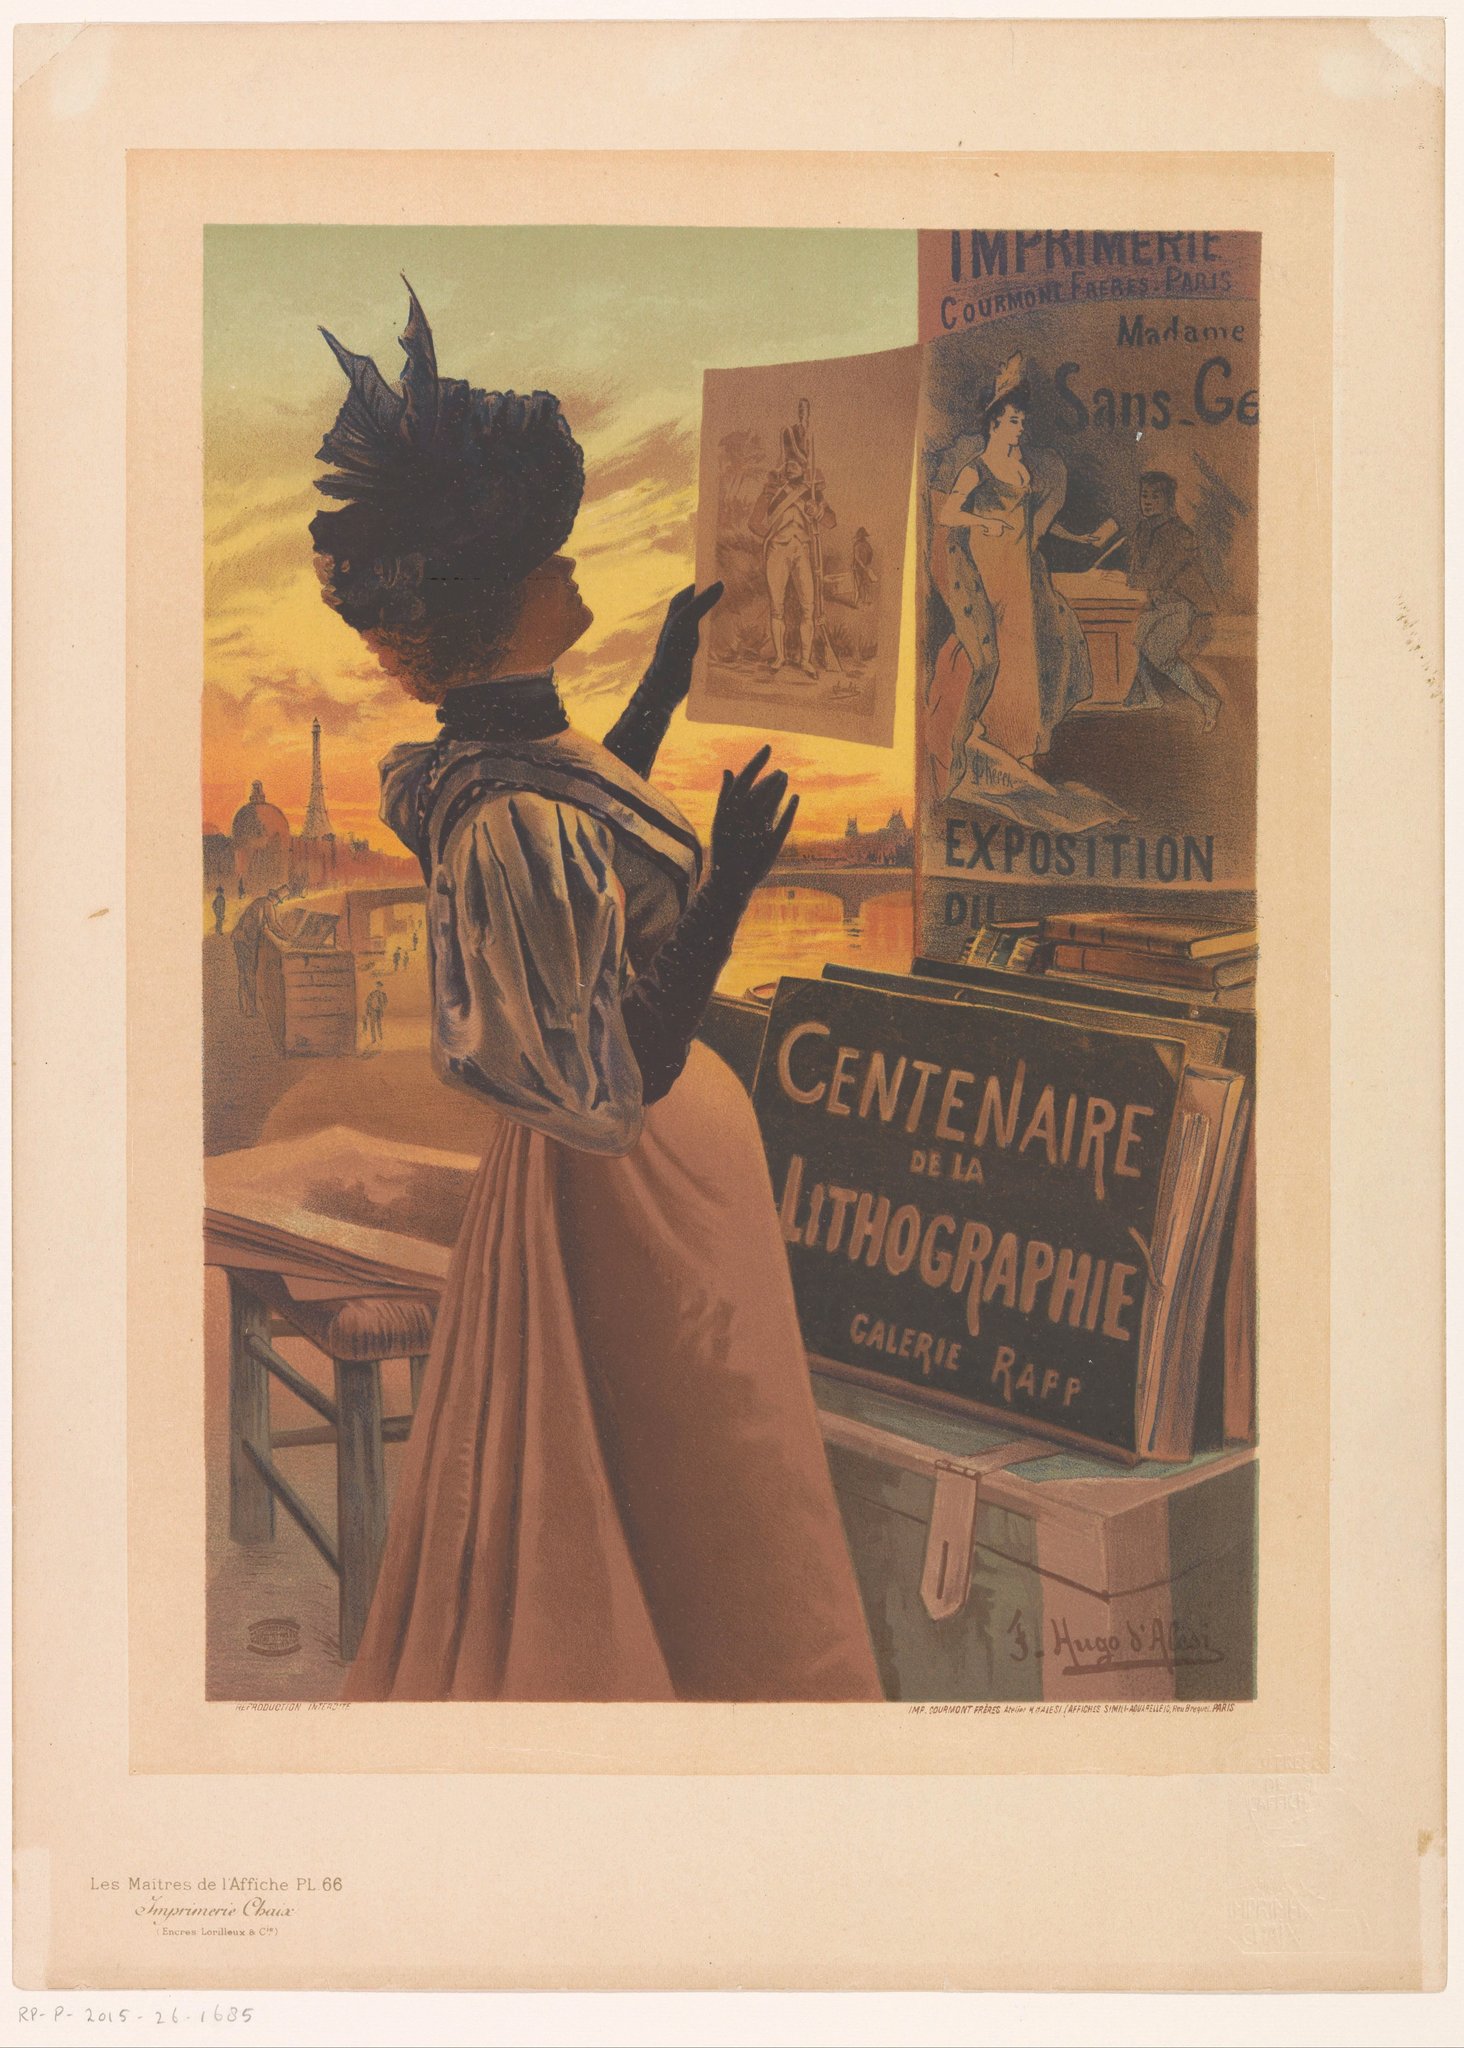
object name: print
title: Les Maîtres de l'Affiche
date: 1895-1900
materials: paper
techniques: lithograph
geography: paris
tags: newspaper, news-sheet, eiffel tower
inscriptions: collector's mark: Lugt 4780, collector's mark: Lugt 2228, stamp: Lugt 1777c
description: Een vrouw voor de kraam van een prenthandelaar op een Parijse kade bij zonsondergang. In haar hand houdt ze een prent met een soldaat. In de achtergrond de Eiffeltoren.